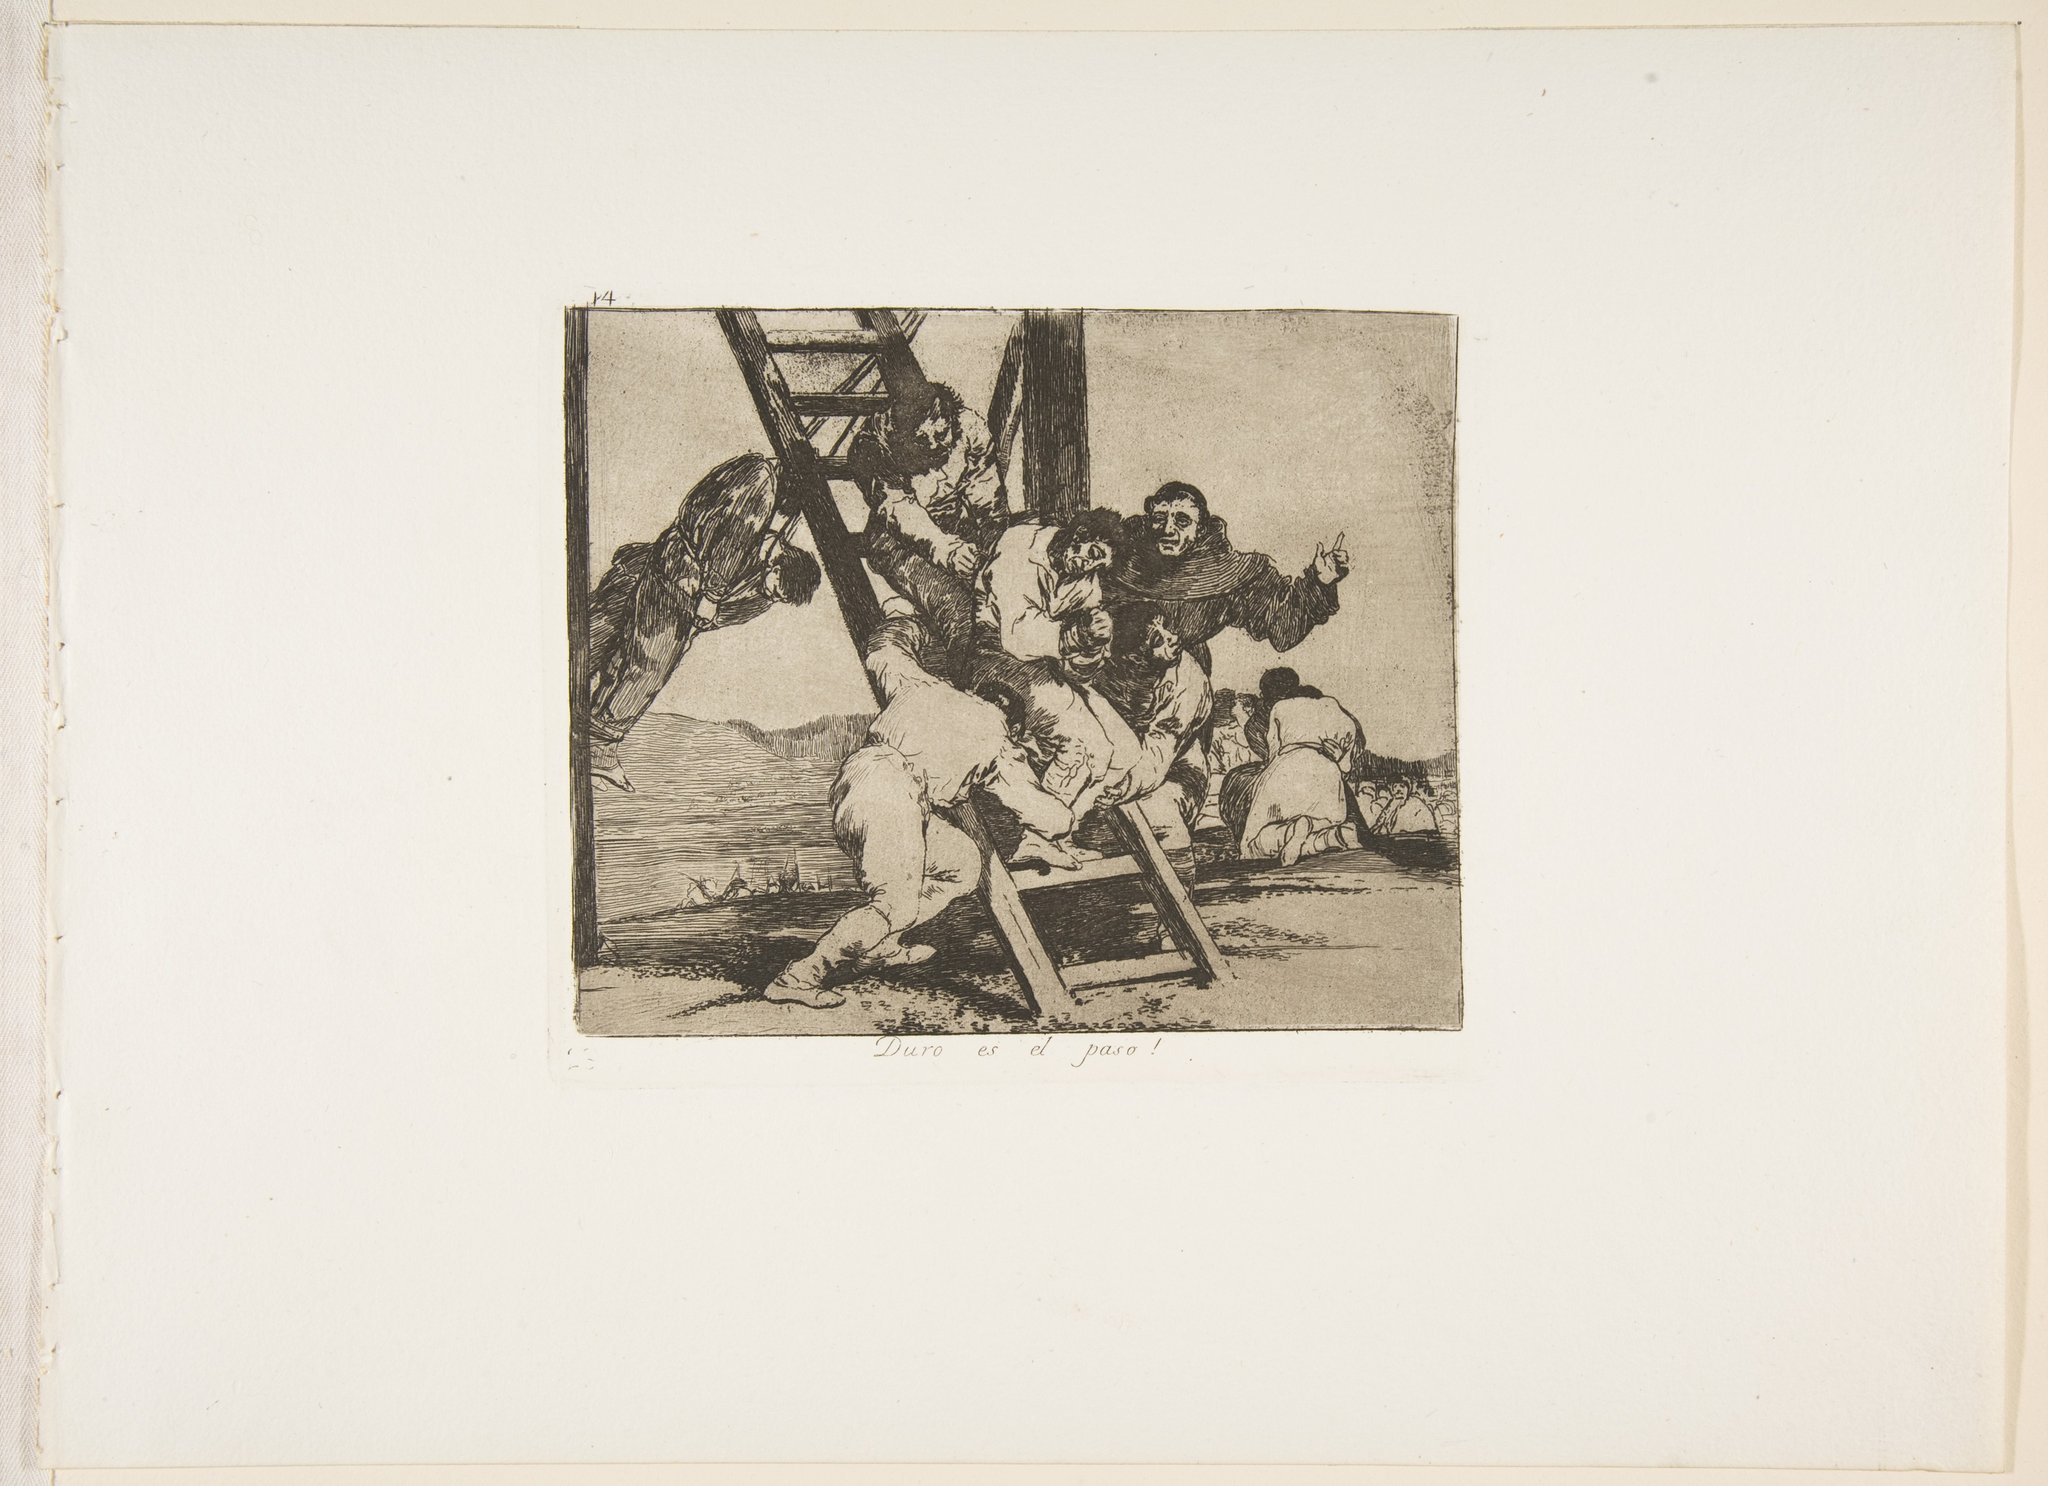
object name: print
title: Plate 14 from "The Disasters of War" (Los Desastres de la Guerra): 'It's a hard step!' (Duro es el paso!)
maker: goya (francisco de goya y lucientes)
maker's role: artist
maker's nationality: spanish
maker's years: 1746-1828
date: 1810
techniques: engraving, burnishing, drypoint, etching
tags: men,ladders